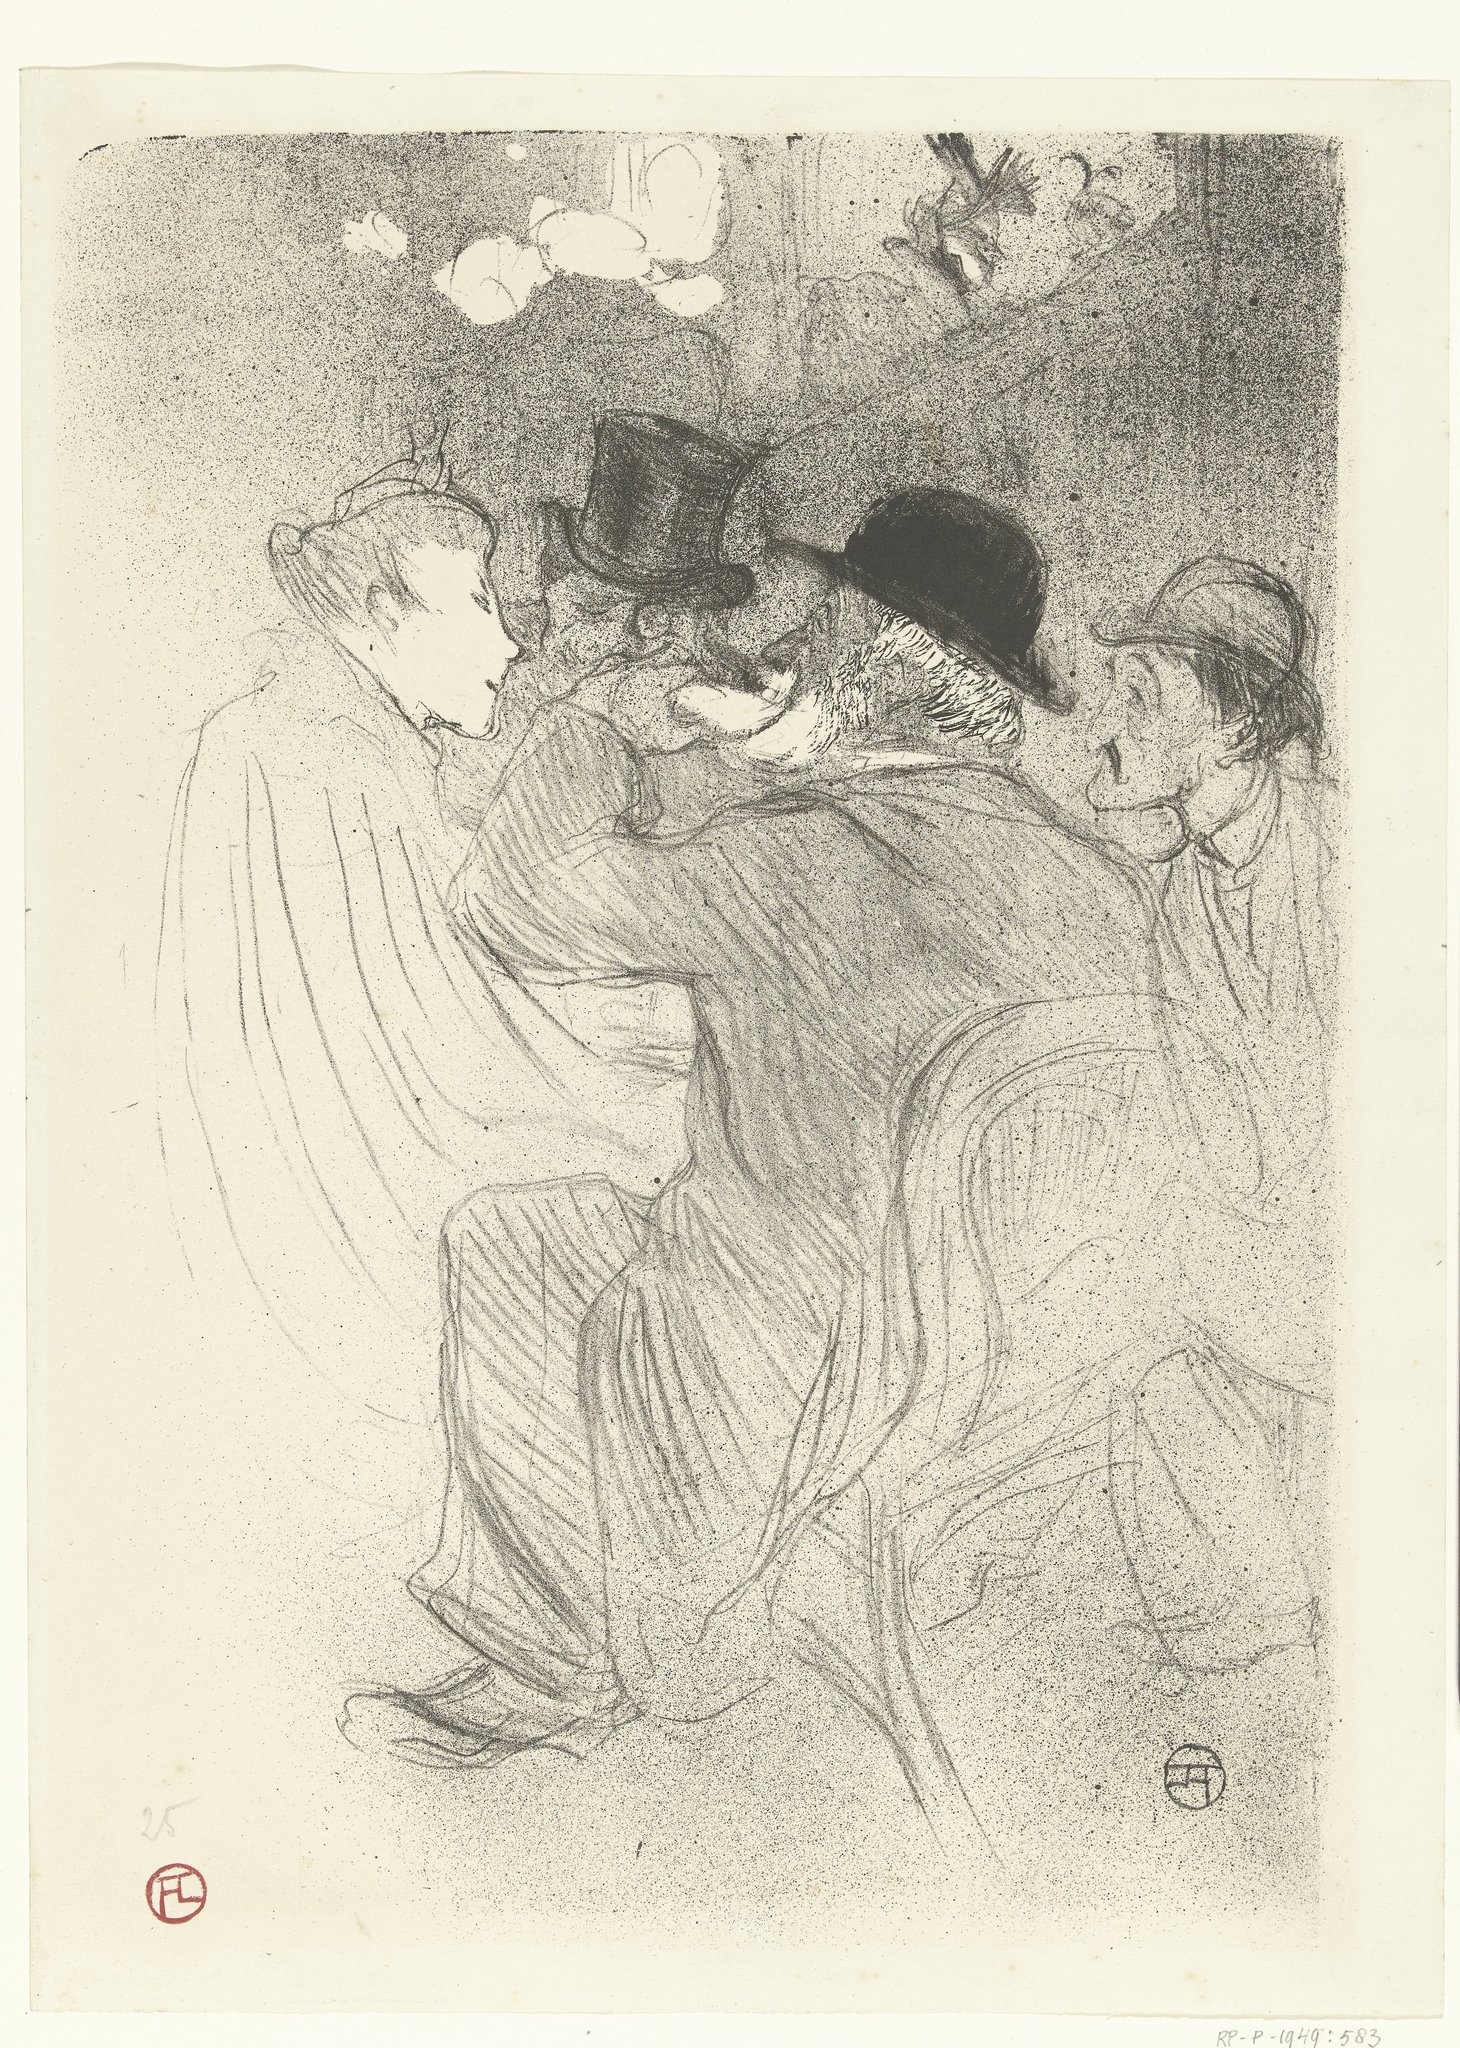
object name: print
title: Bezoekers in café Moulin Rouge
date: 1893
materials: paper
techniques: lithograph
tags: inn, coffee-house, public house, etc.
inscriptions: collector's mark: Lugt 2760, stamp: Lugt 1338, collector's mark: Lugt 2228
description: Lithografie gepubliceerd in: L'Escarmouche, 10 december 1893 (reproductie). De lithografie verscheen in een oplage van honderd exemplaren en werd los verkocht voor de financiering van dit nieuwe tijdschrift.